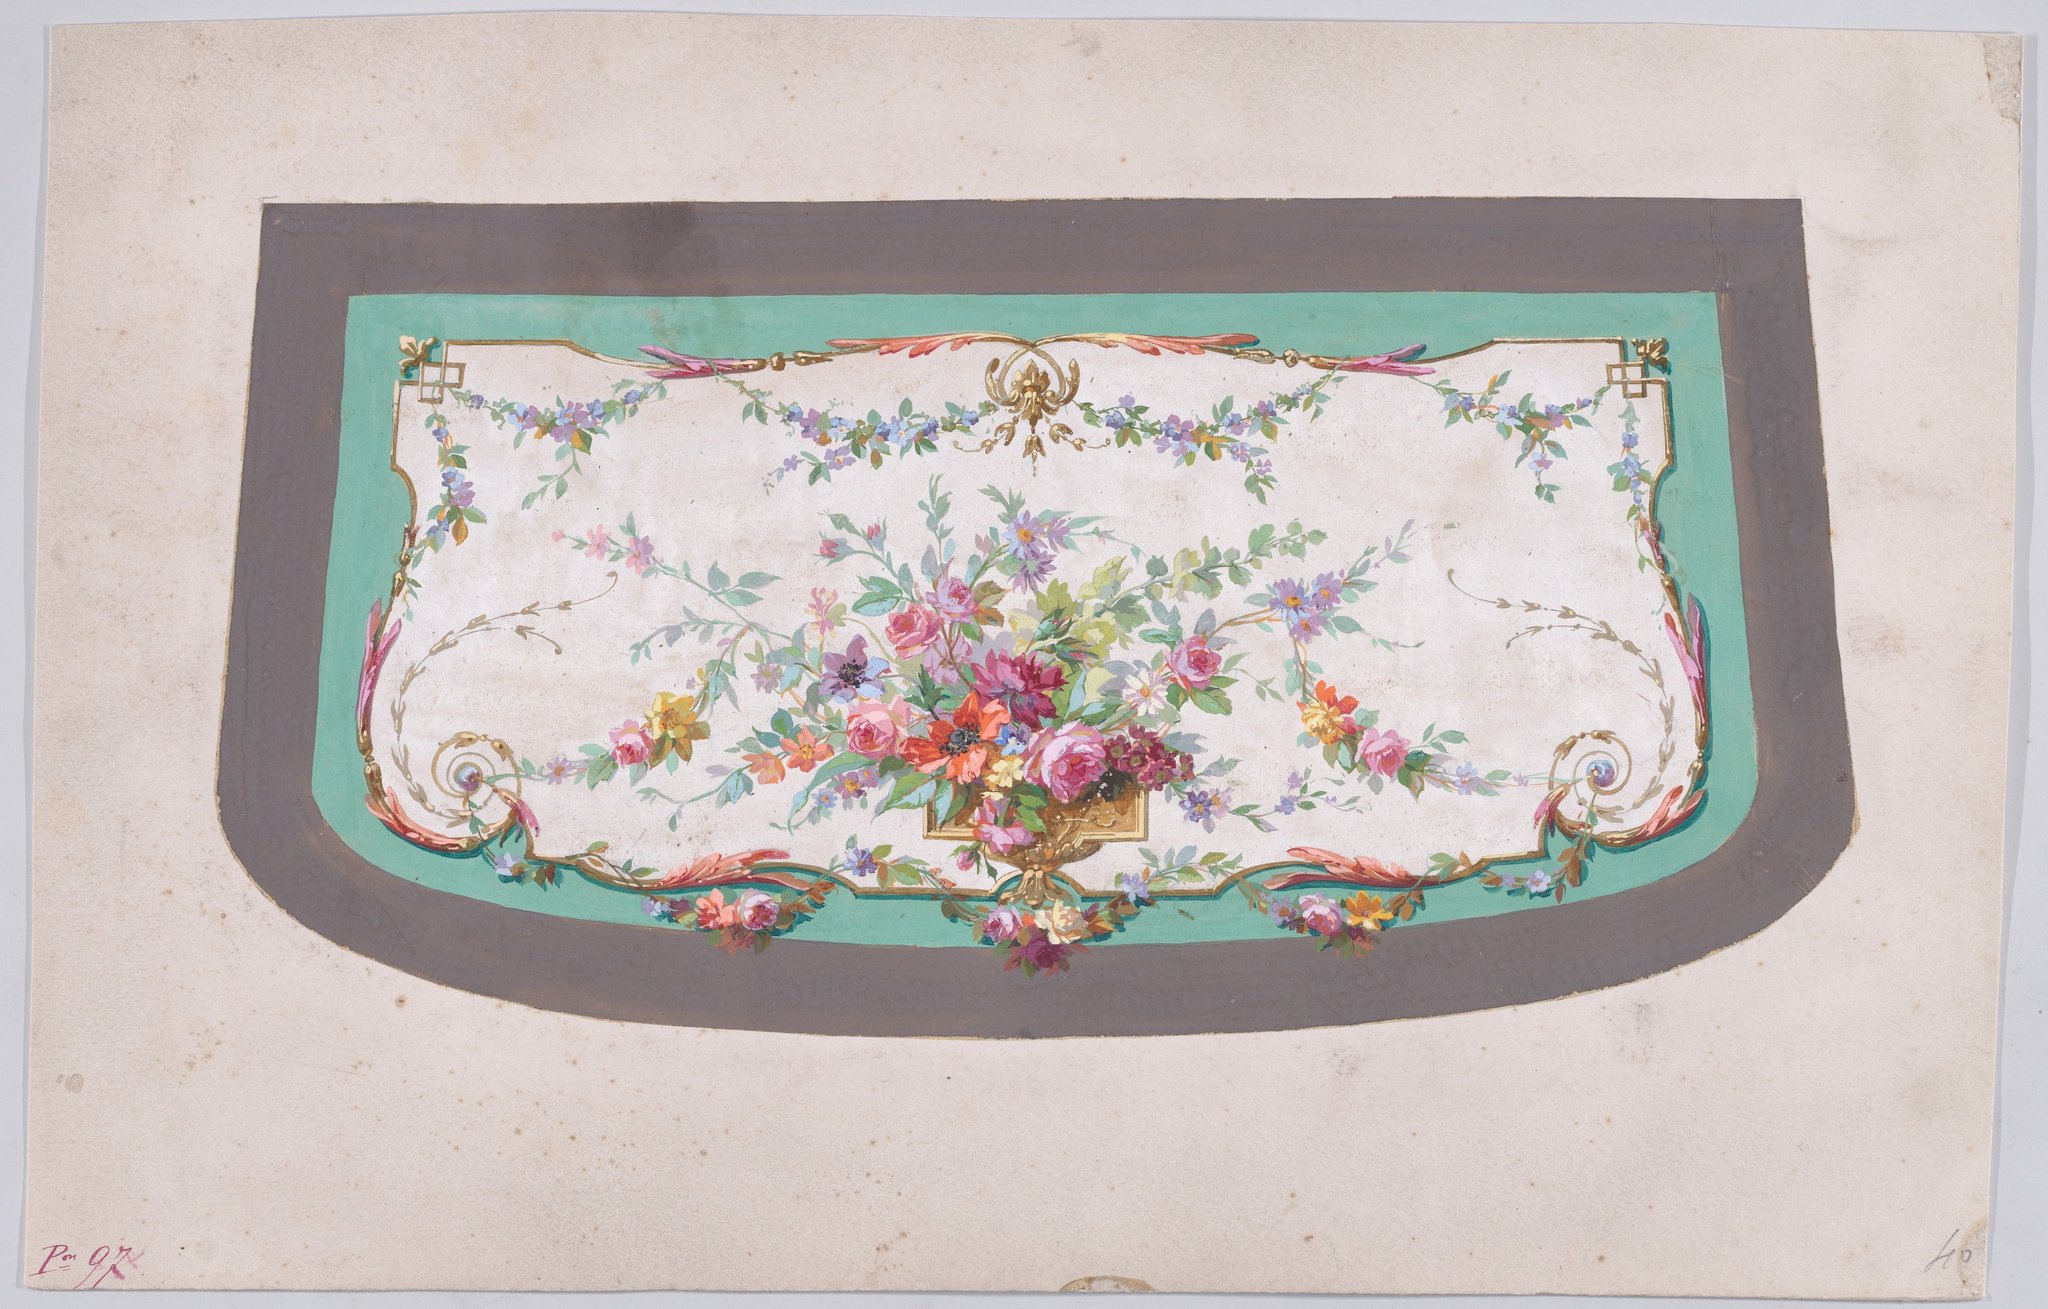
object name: drawing ornament architecture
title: Design for a Sofa Seat Cover (?) with an Ornamental Frame Containing a Vase with a Large Bundle of Flowers and Leaves and Decorated with Acanthus Leaves and Two Fleurs de Lys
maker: anonymous, french, 19th century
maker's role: designer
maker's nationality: french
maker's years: 1800-1900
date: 1870-1900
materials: watercolor